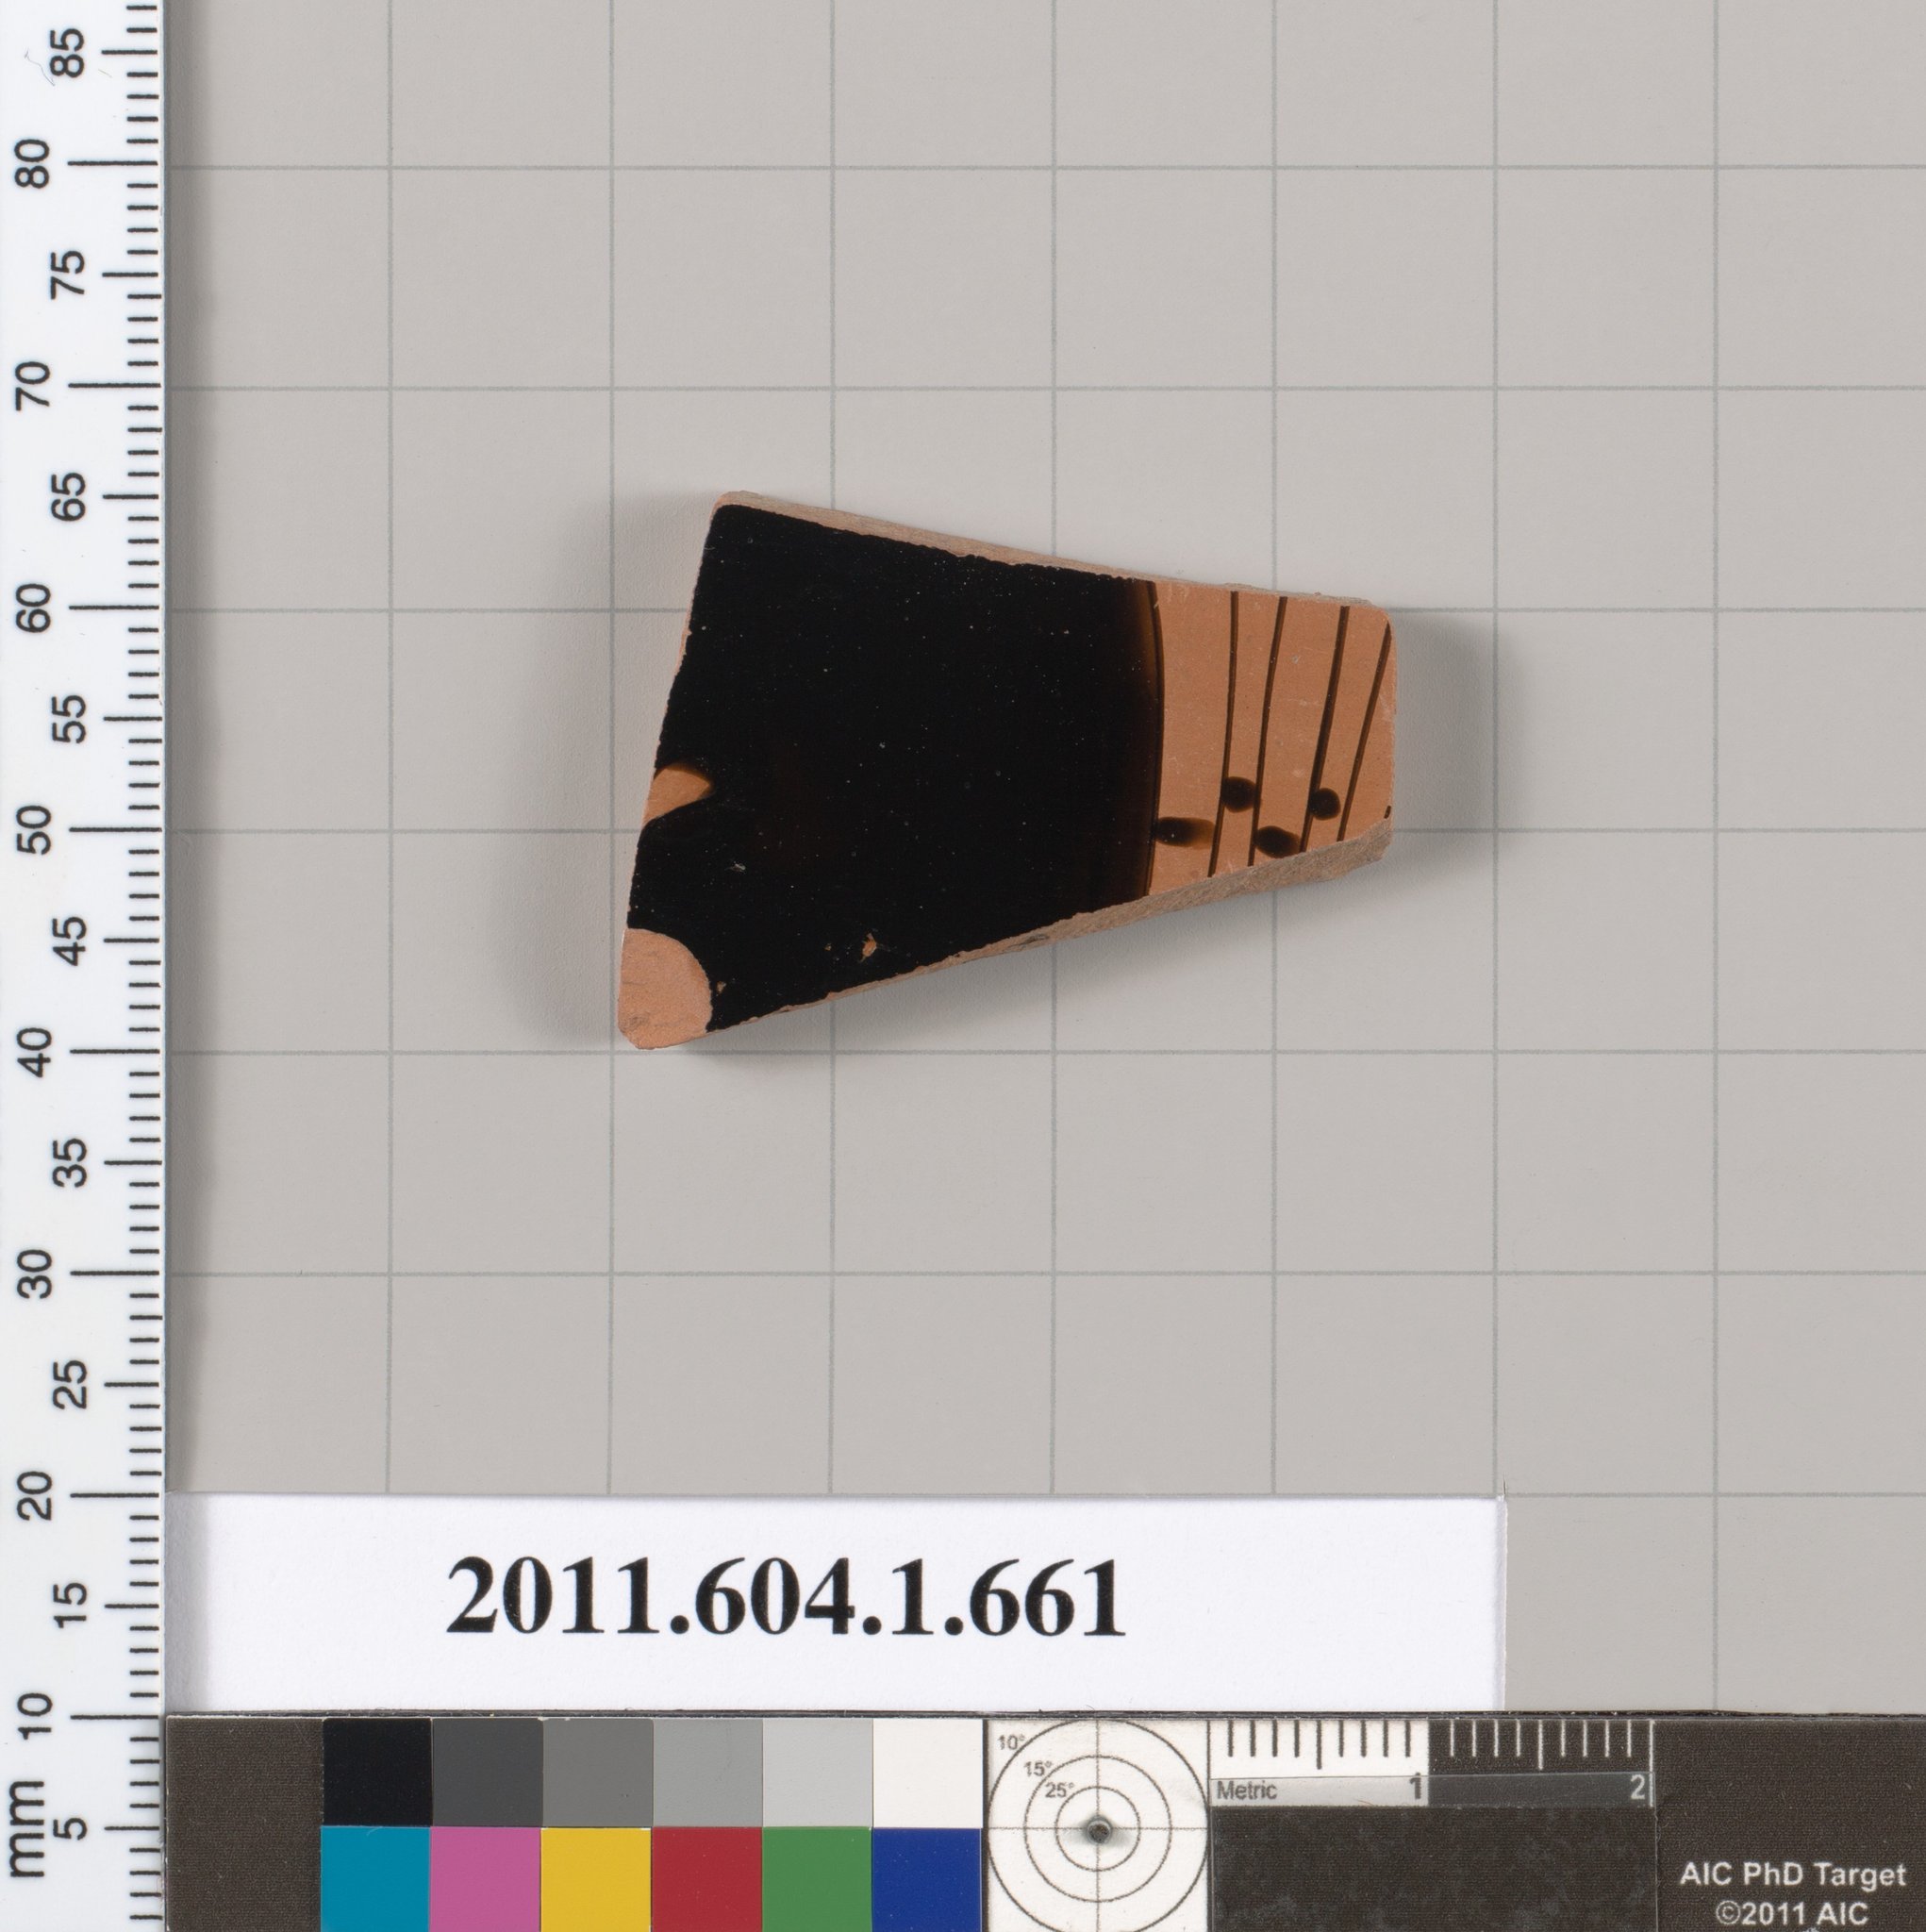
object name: kylix fragment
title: Terracotta fragment of a kylix (drinking cup)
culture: greek, attic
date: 475-451 BCE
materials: terracotta